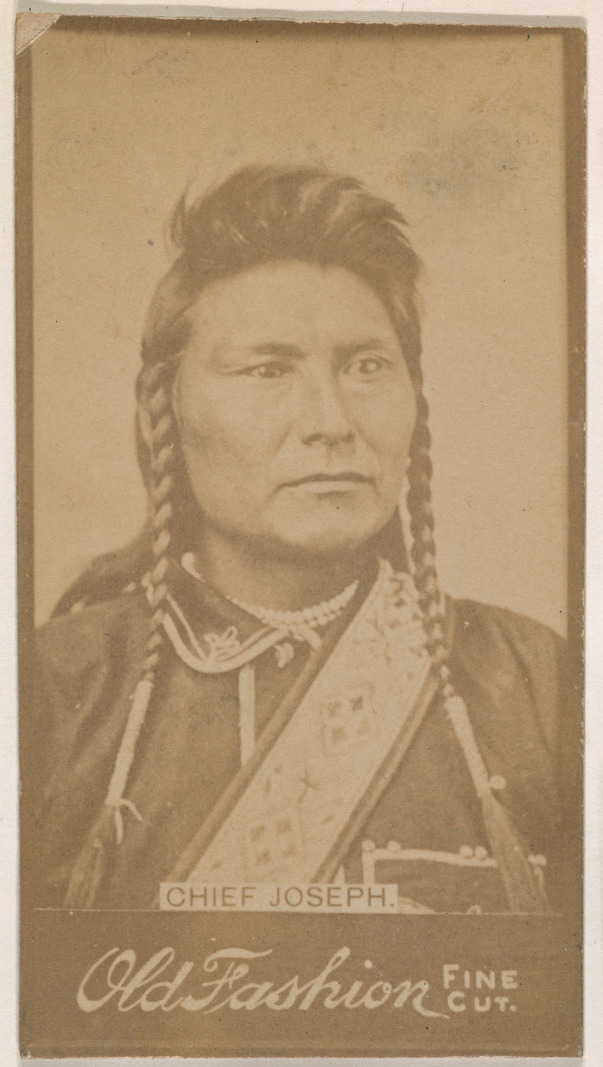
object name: photograph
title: Chief Joseph, from the Indian Chiefs series (N681) promoting Old Fashion Fine Cut Tobacco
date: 1888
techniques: albumen silver print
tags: men,portraits